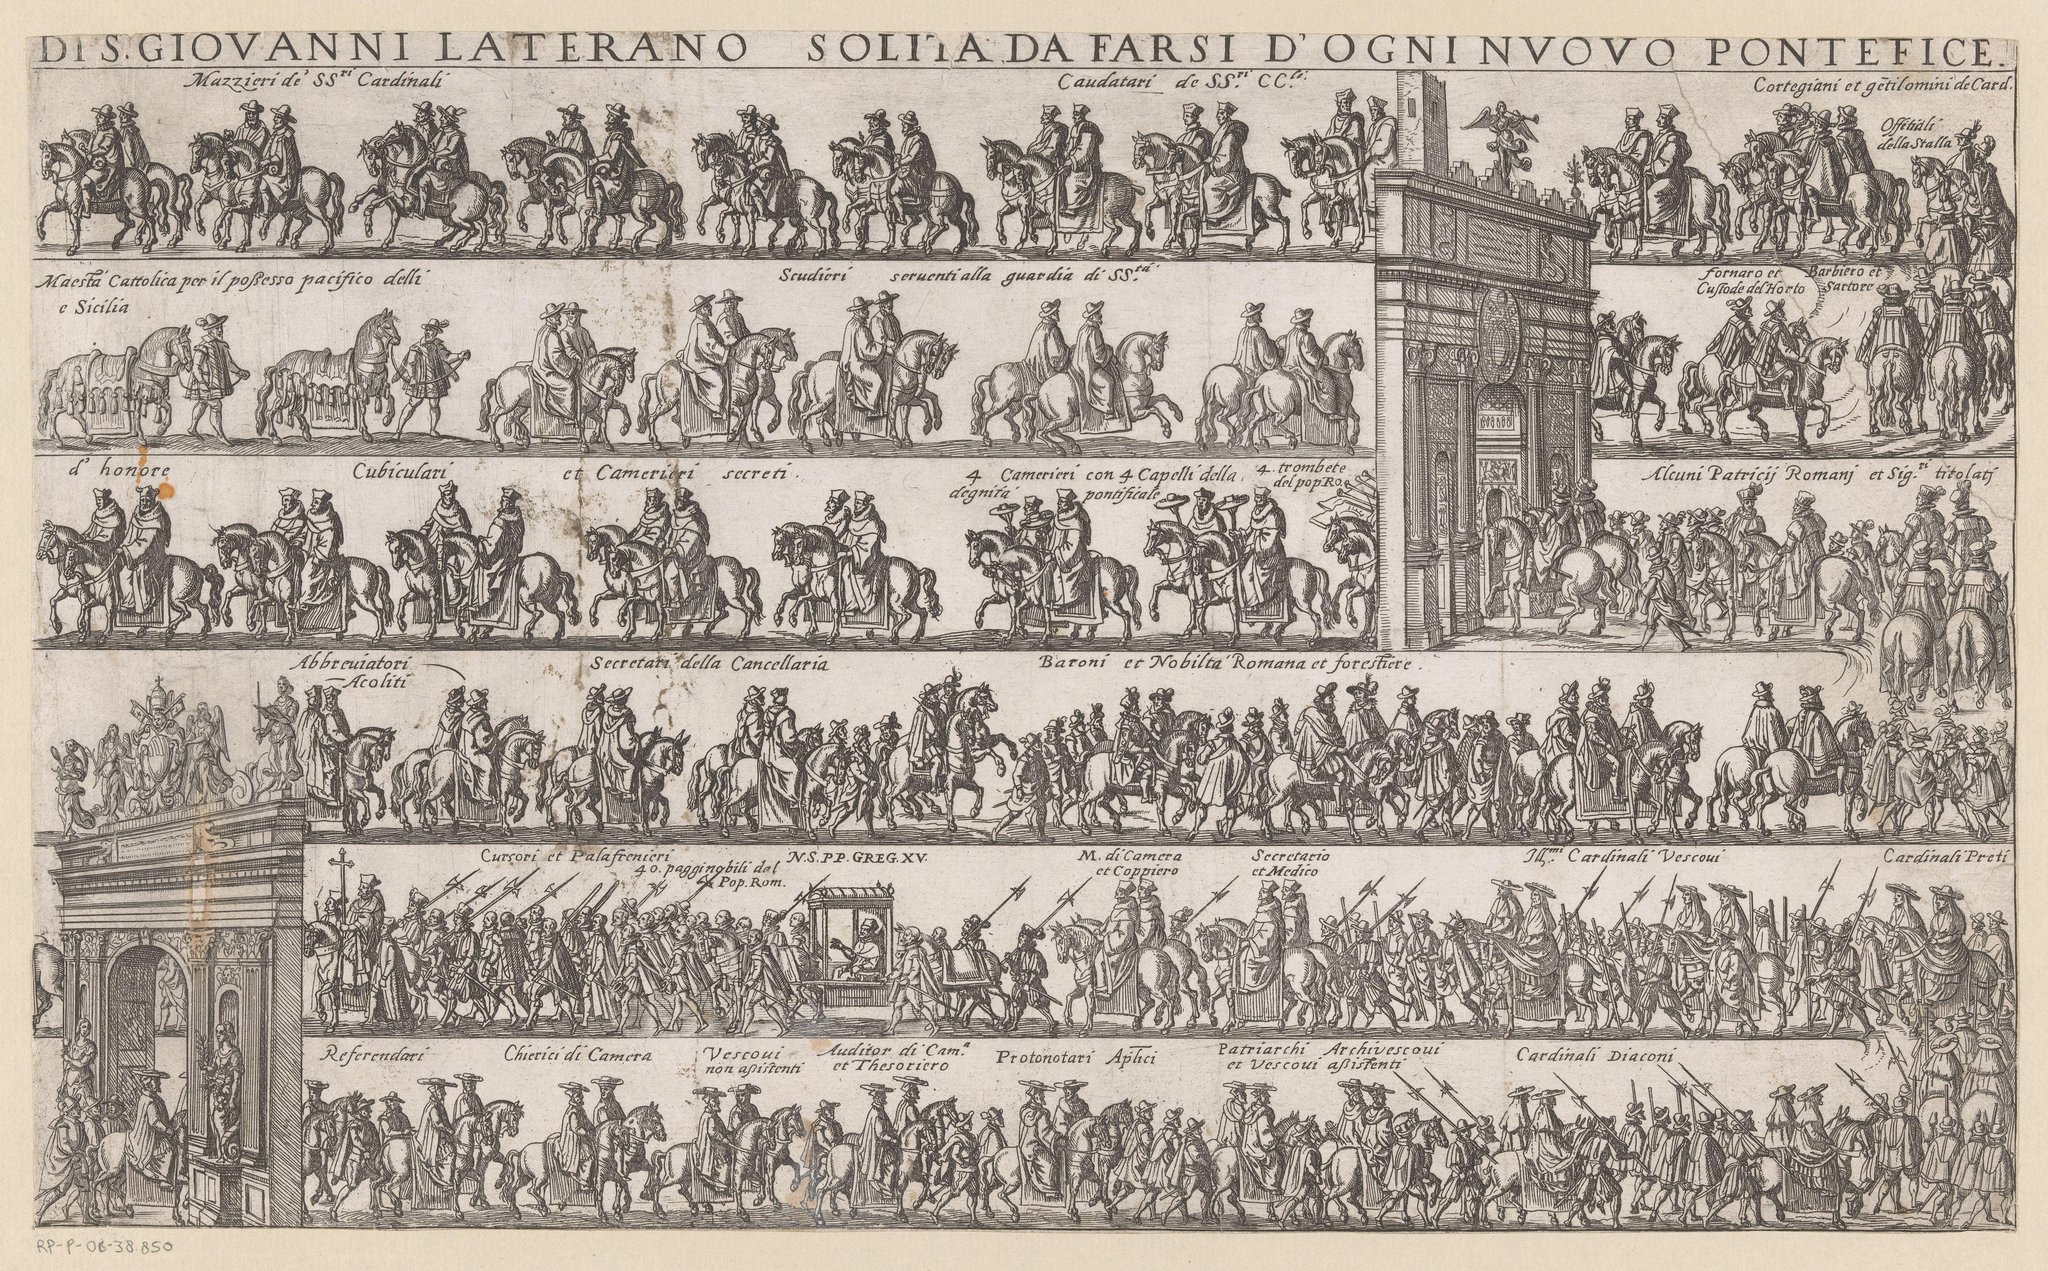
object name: print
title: Ordine della cavalcata pontificale dal Vaticano al possesso di S. Giovanni Laterano solita da farsi d'ogni nuovo pontefice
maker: Anonymous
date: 1621-1623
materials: paper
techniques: etching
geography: italy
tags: rome, gregorius xv, papal coronation procession, city-gate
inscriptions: collector's mark: Lugt 240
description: Pauselijke processie (cavalcata papale) van de Sint-Pietersbasiliek in het Vaticaan naar de Sint-Jan van Lateranen in Rome, die gewoonlijk werd afgelegd na de kroning van een nieuwe paus. De processie loopt over zes horizontale banen, waarbij de figuren drie keer een poort passeren.